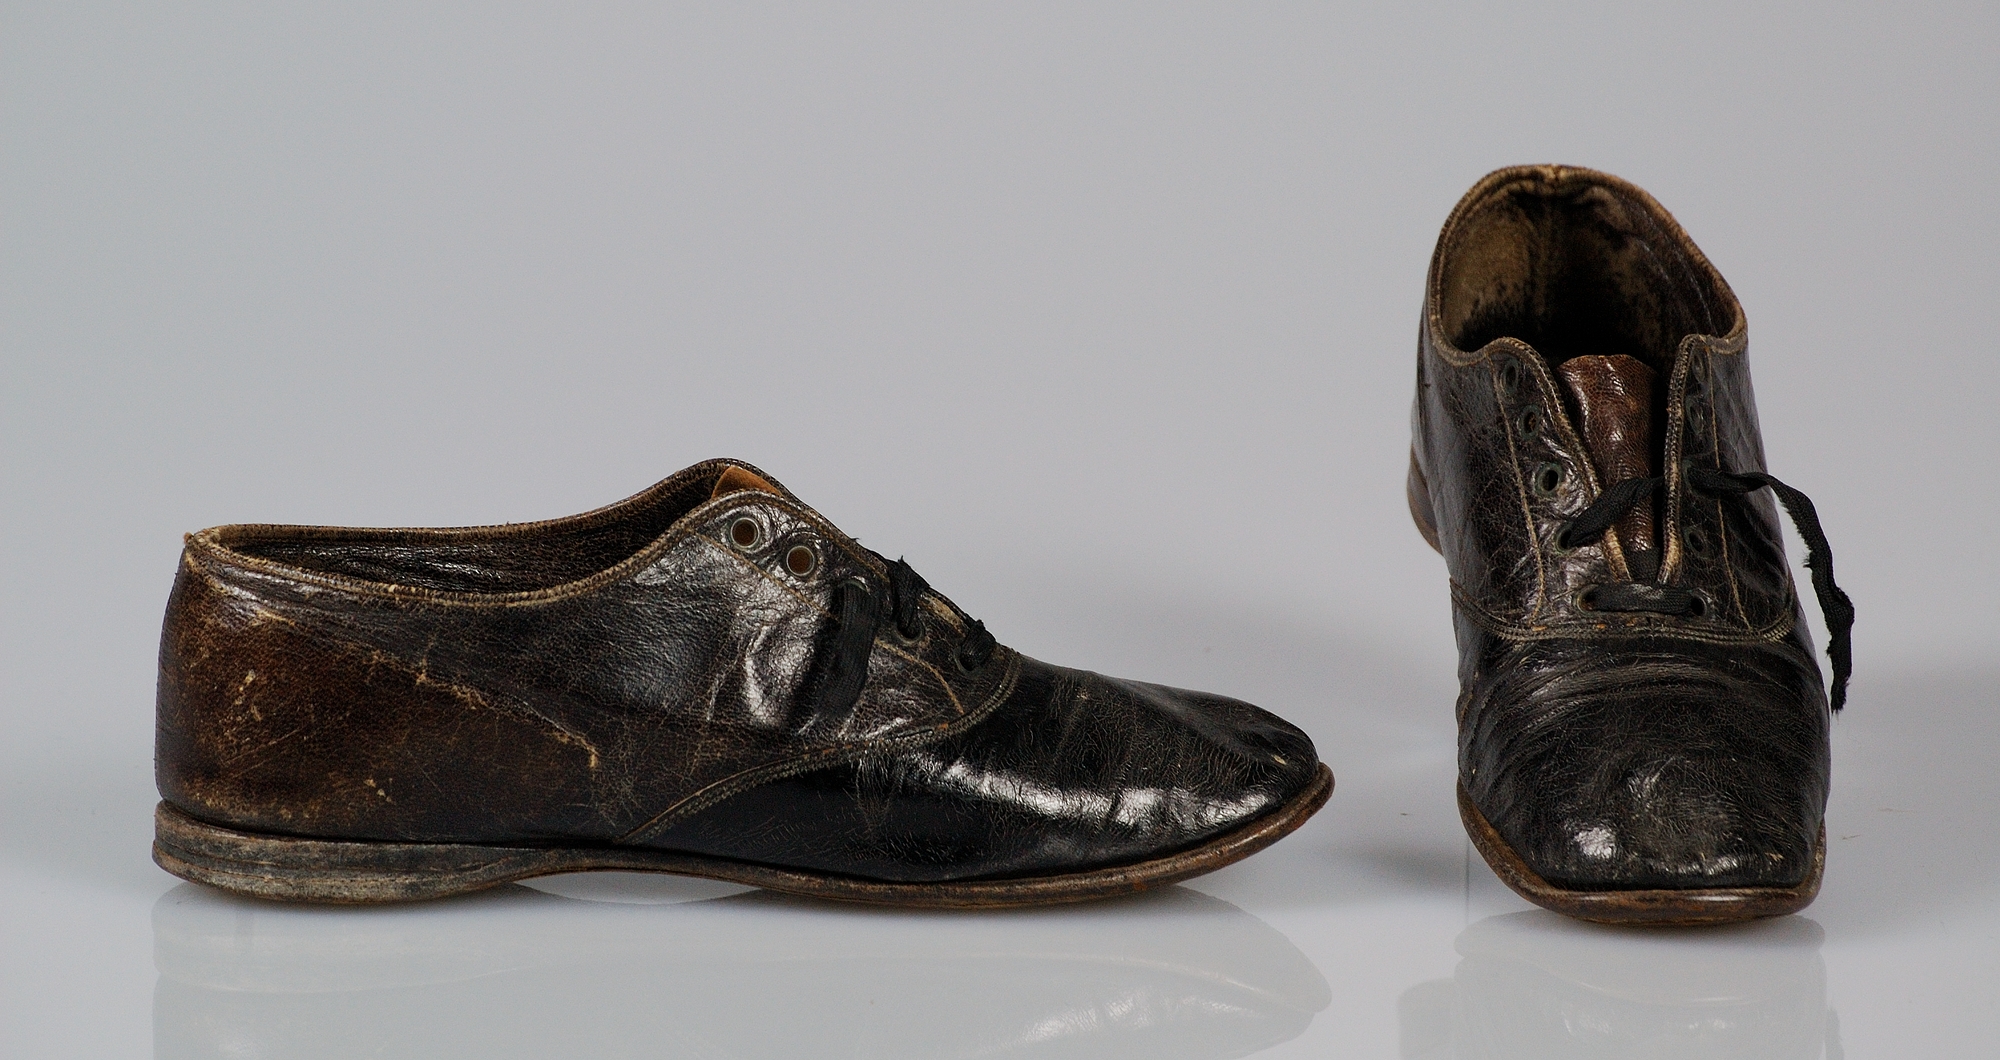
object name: oxford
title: Oxfords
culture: american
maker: a. alexander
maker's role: designer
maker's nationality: american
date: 1890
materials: leather